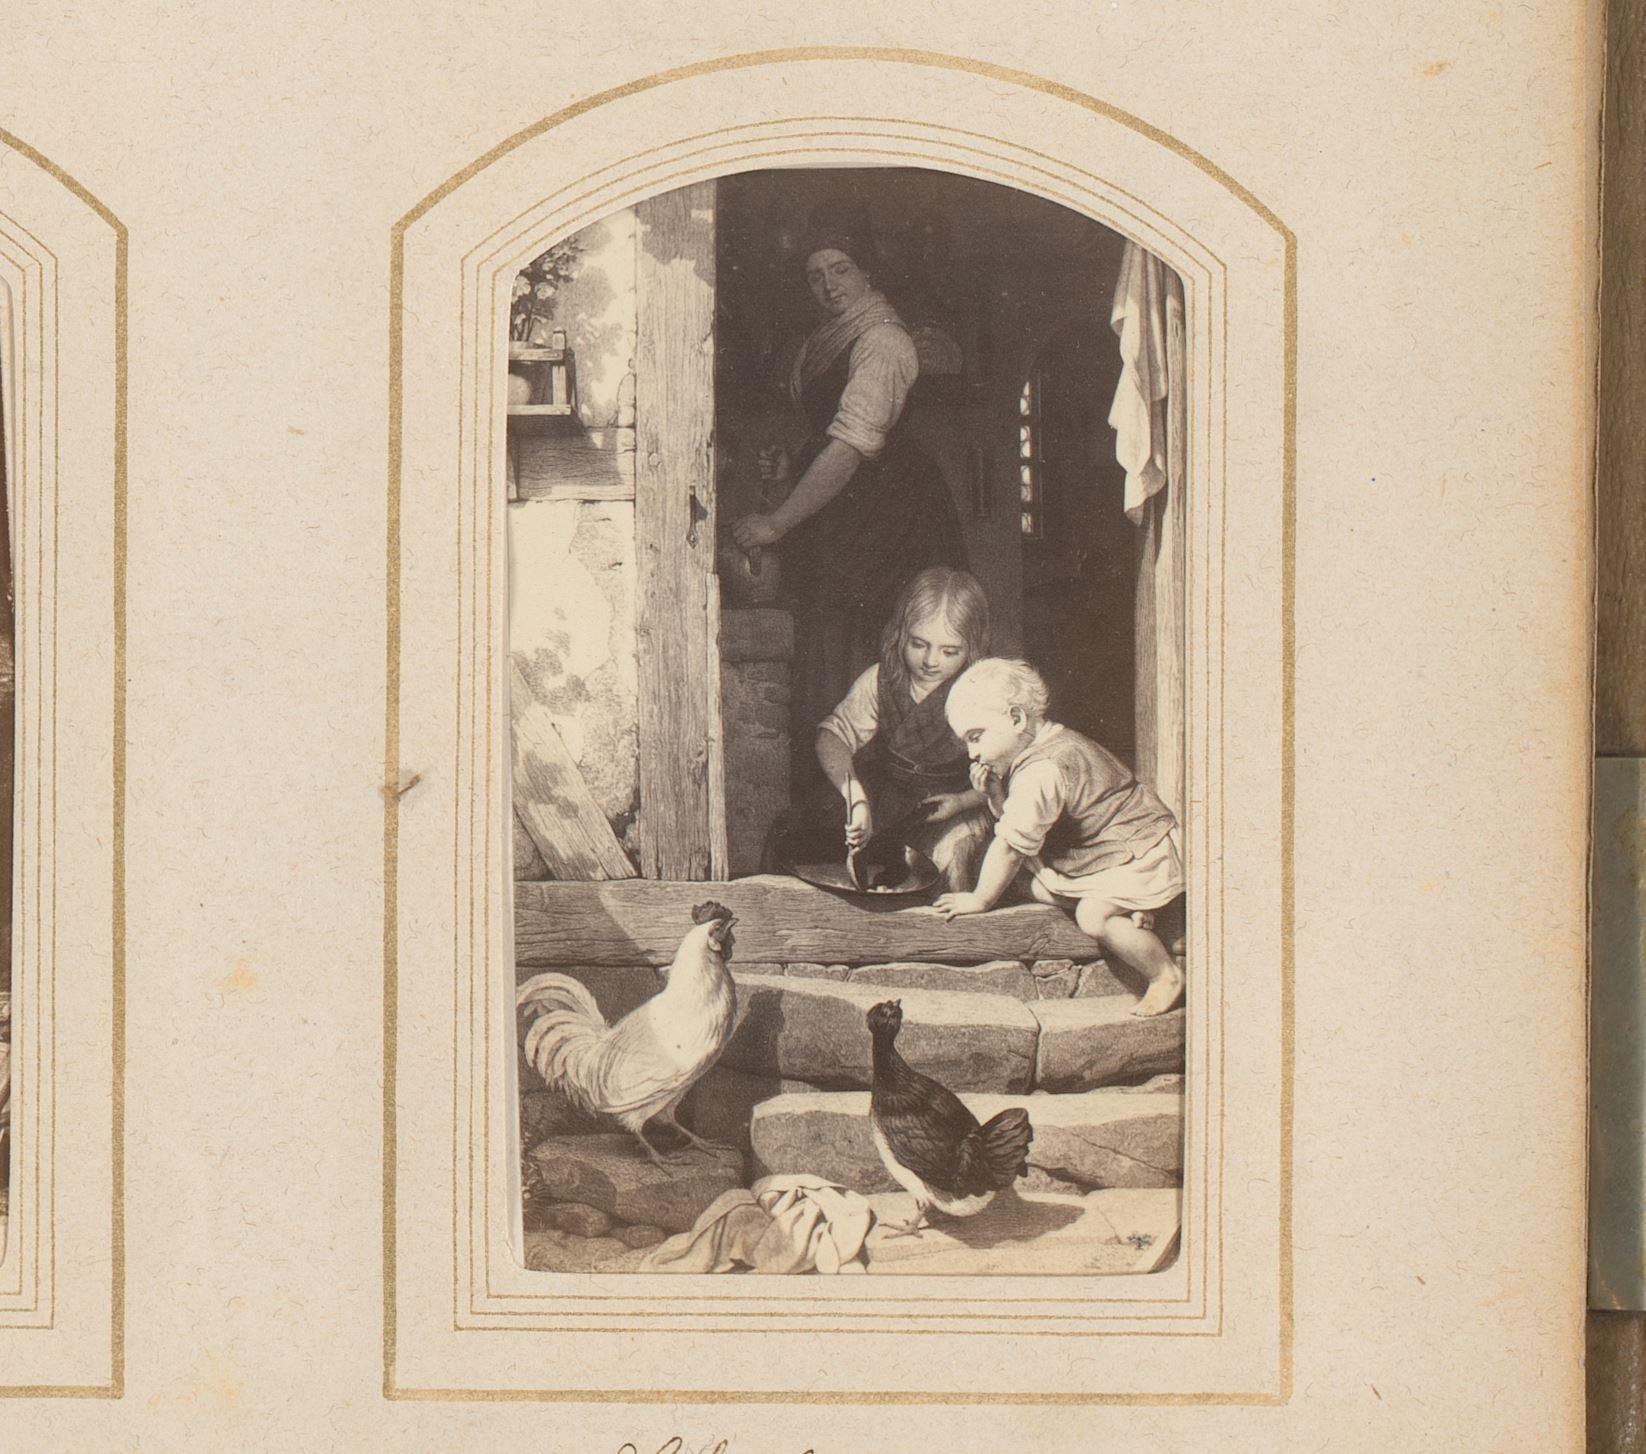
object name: photograph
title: Fotoreproductie van Leckerbissen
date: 1870-1890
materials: cardboard, photographic support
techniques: albumen print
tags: open door, fowl (cock, hen, chicken, etc.), tot, toddler ~ the ages of man, painting, drawing and the graphic arts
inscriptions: annotation: ‘Leckerbissen’, number: ‘178’